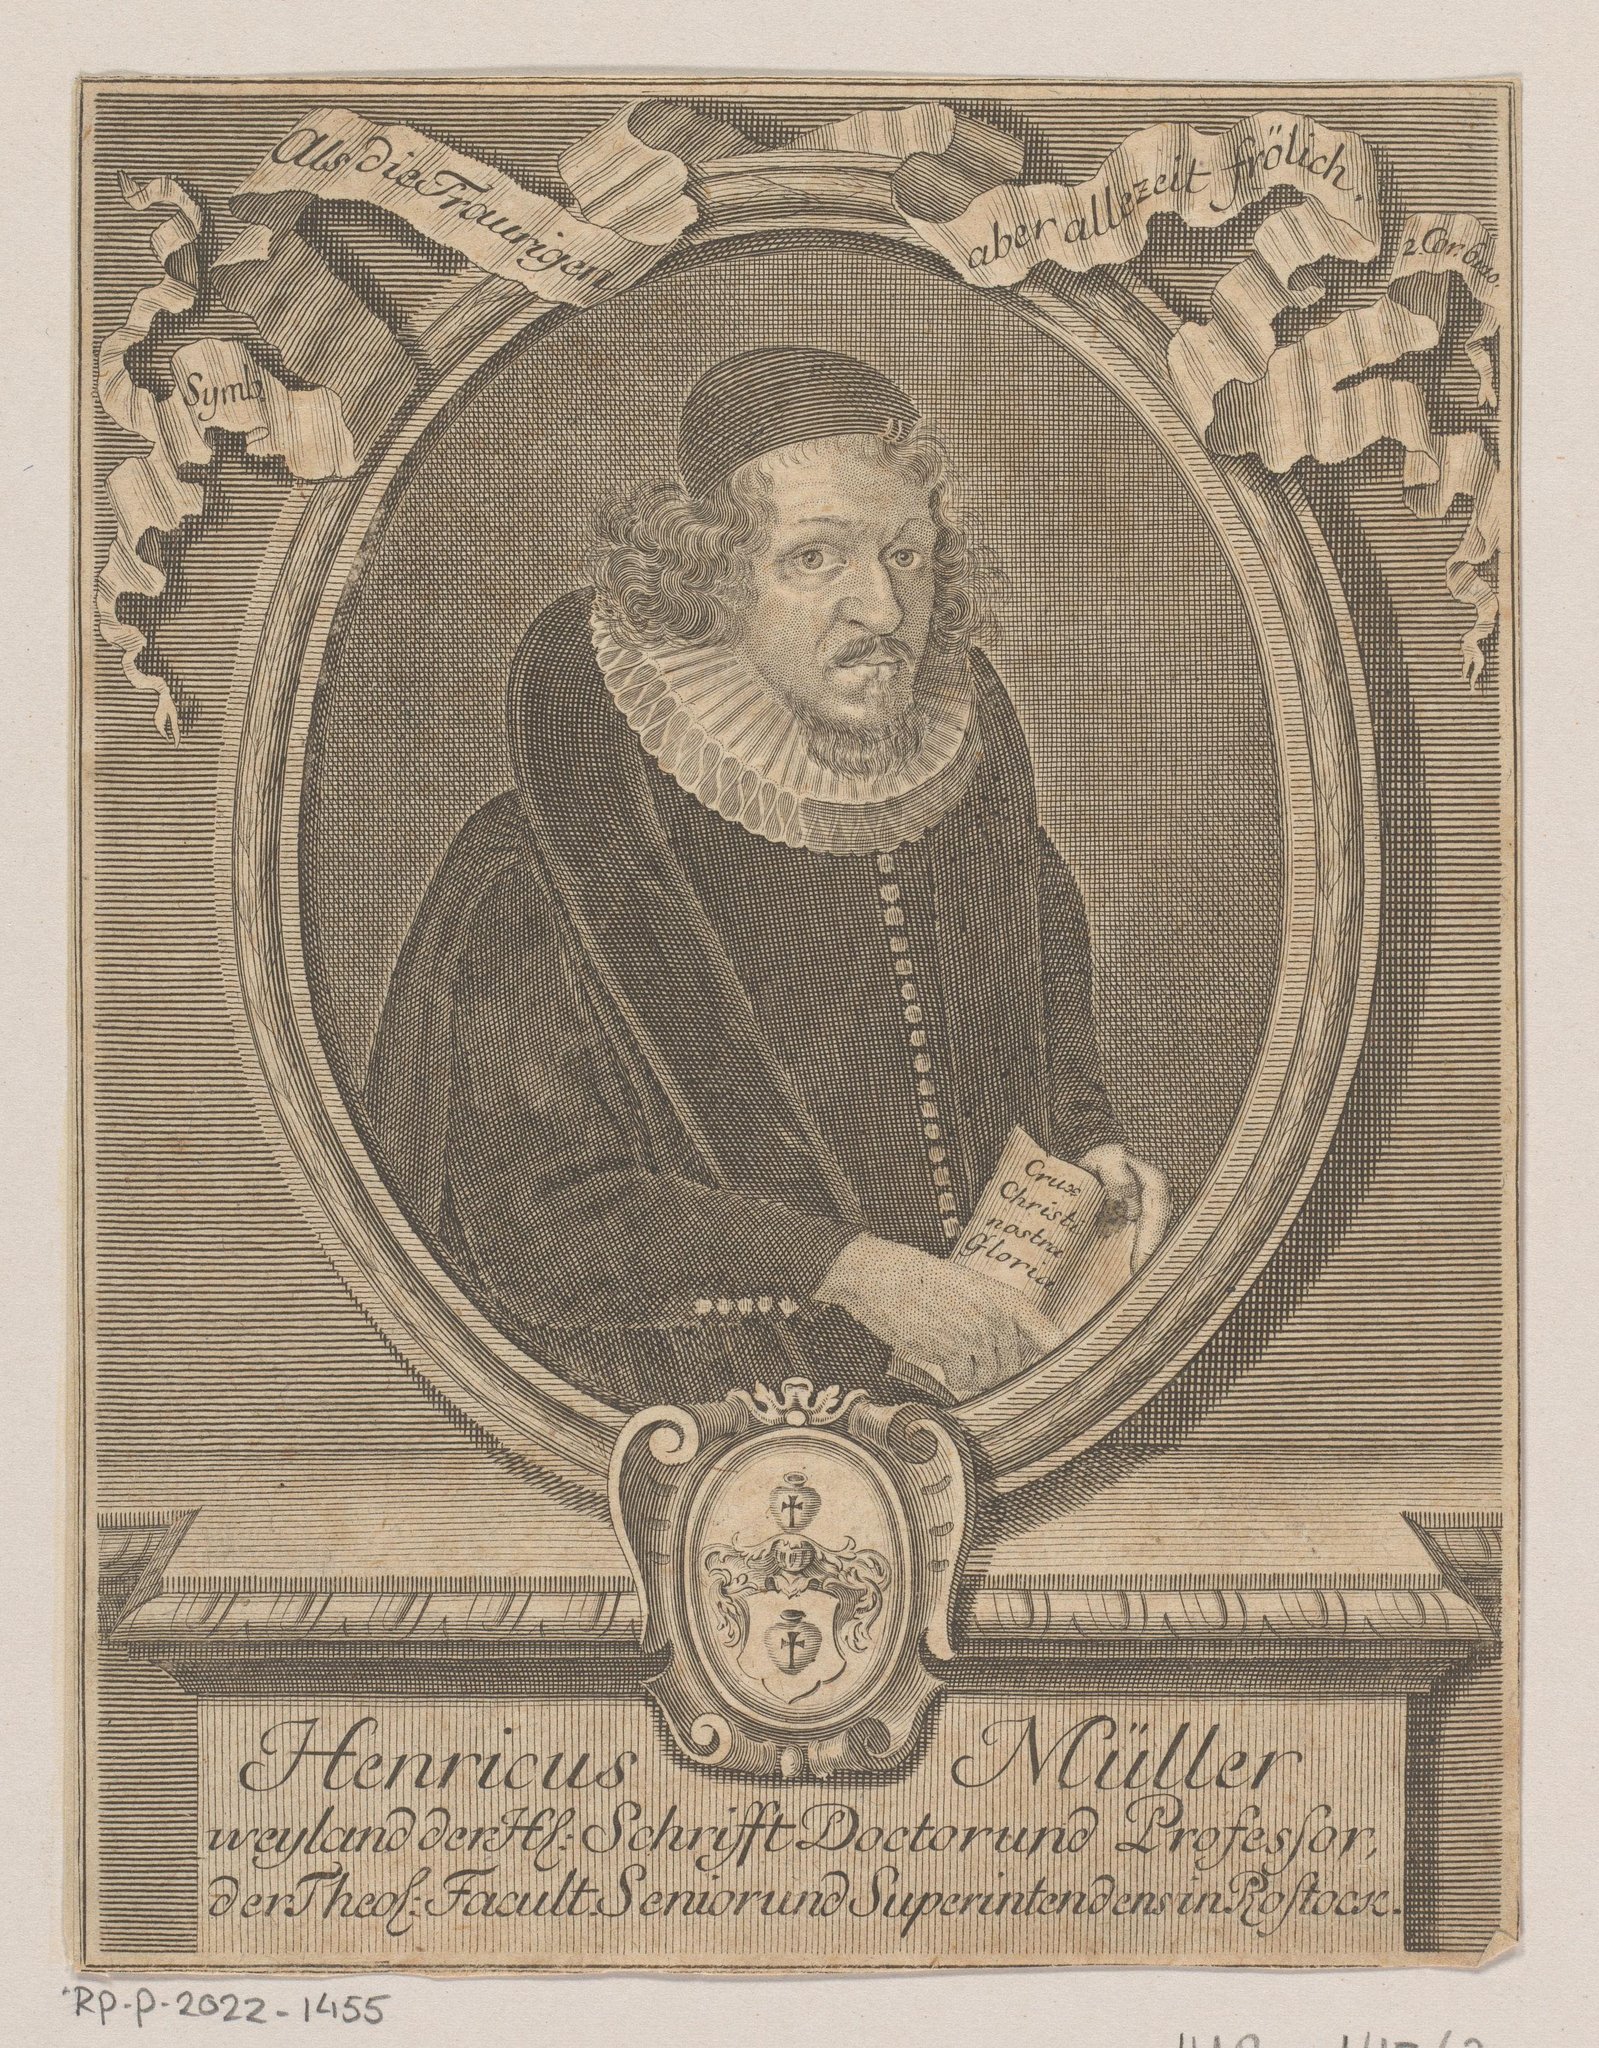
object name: print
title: Portret van Heinrich Müller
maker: johann martin bernigeroth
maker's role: print maker, publisher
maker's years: 1713-1767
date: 1723-1767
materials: paper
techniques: engraving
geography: leipzig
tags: theologian, historical persons